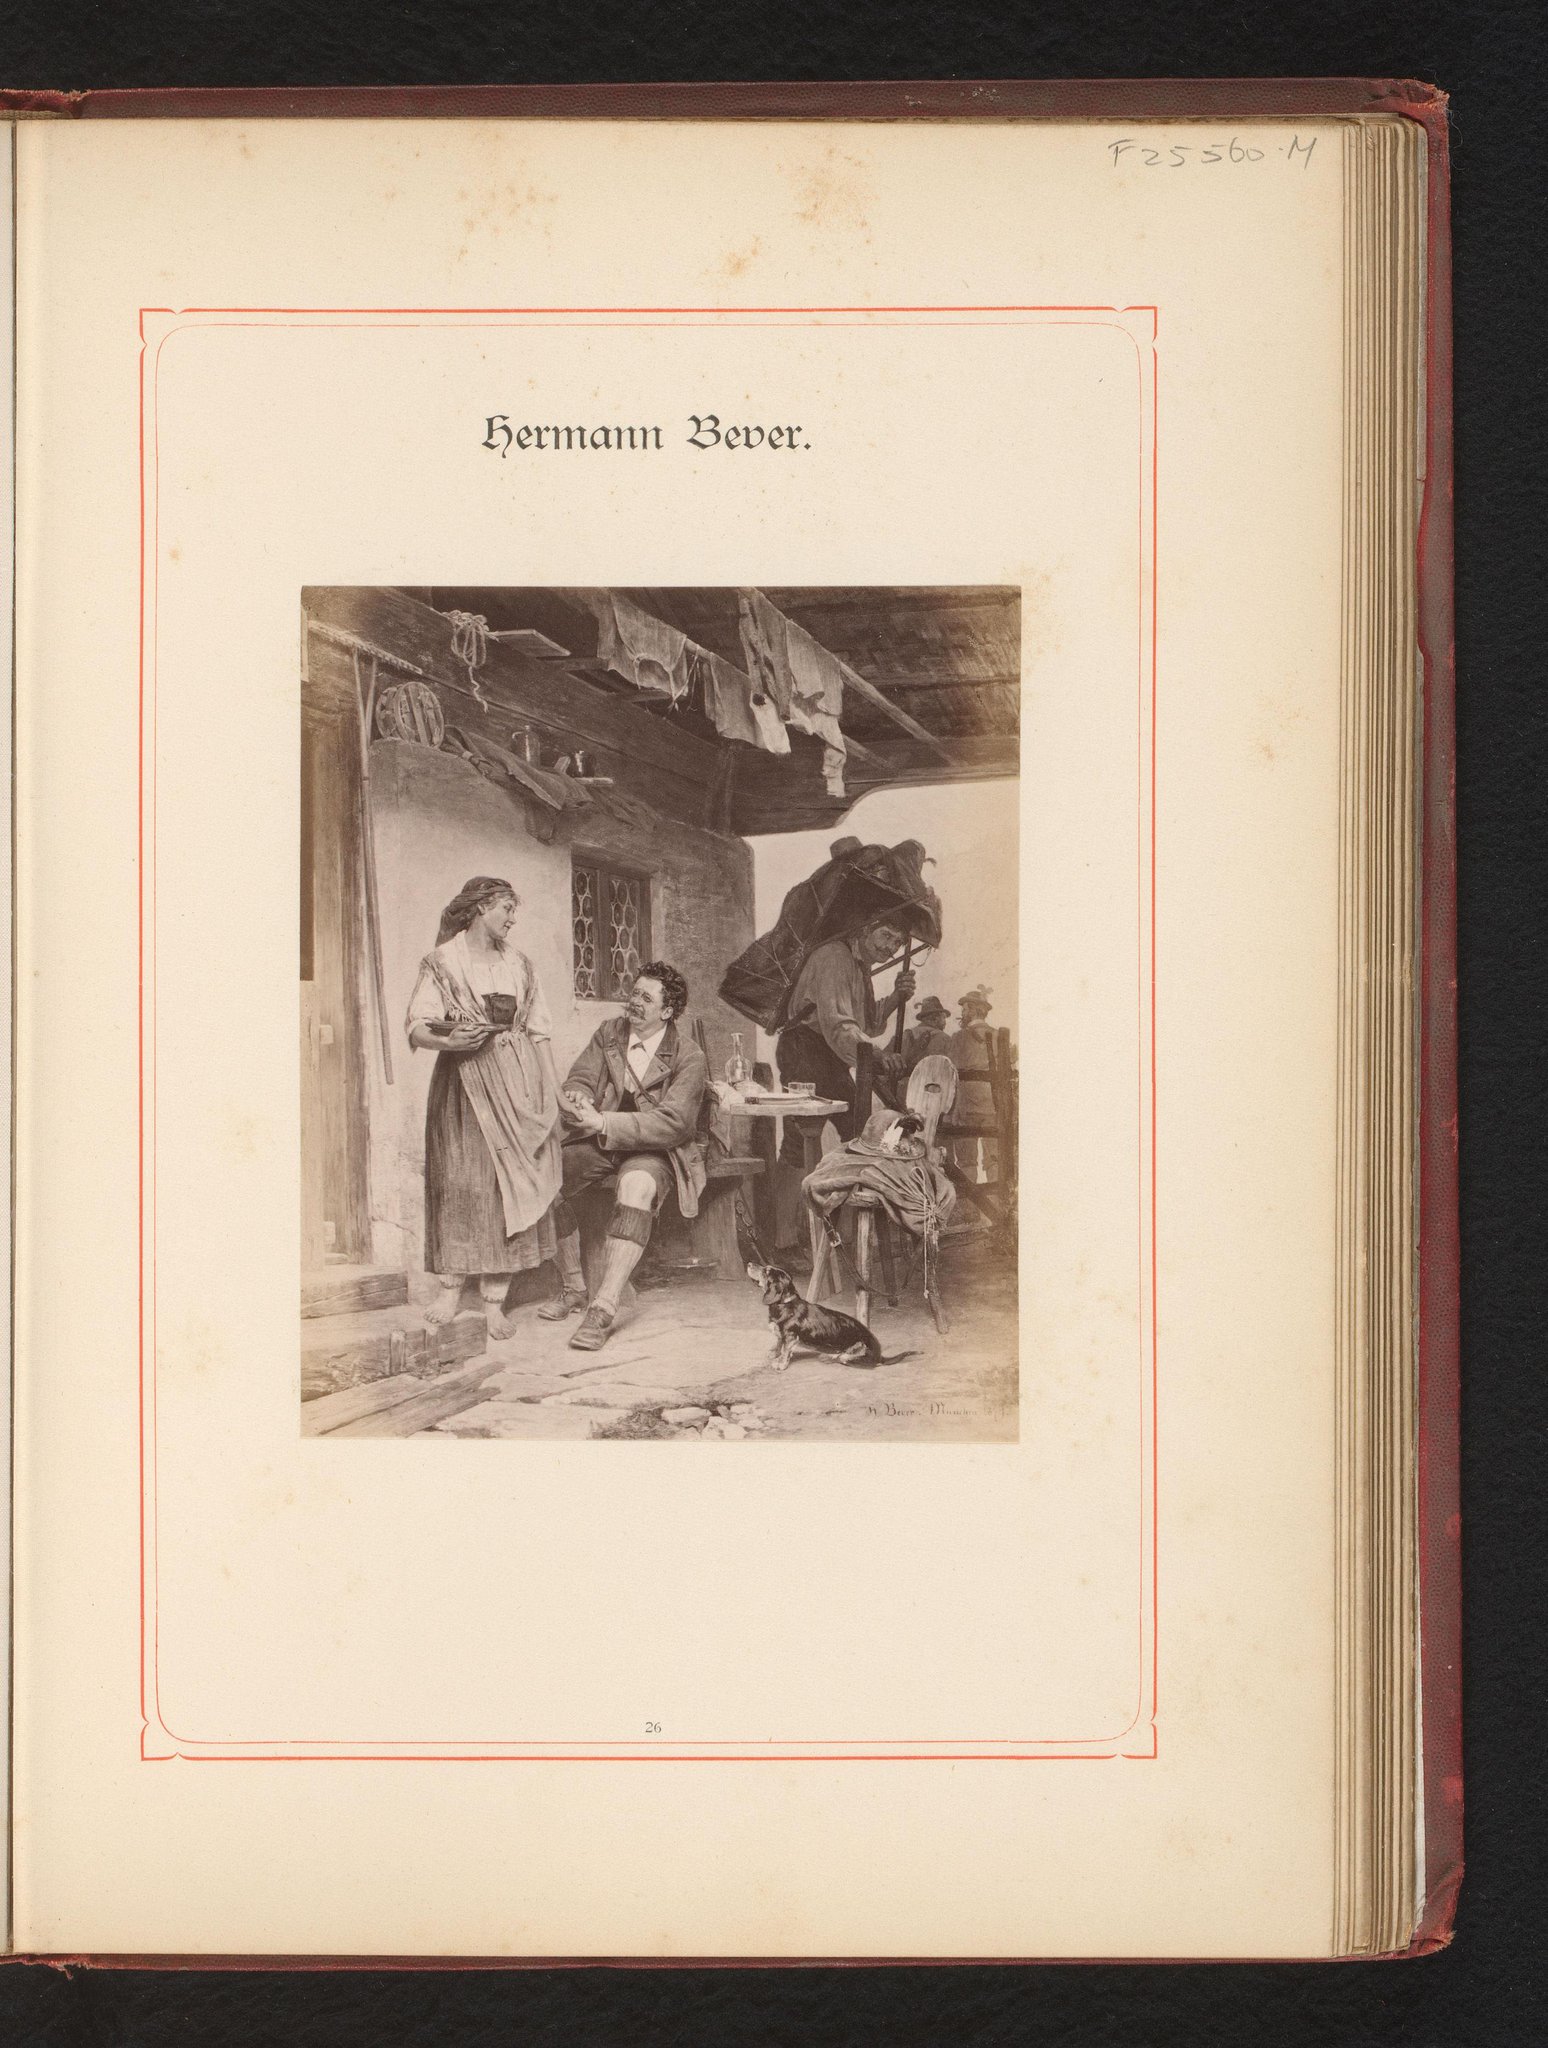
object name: reproduction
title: Fotoreproductie van een schilderij van reizigers bij een herberg door Hermann Bever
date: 1874-1890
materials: paper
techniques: albumen print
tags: picture, painting, hotel, hostelry, inn